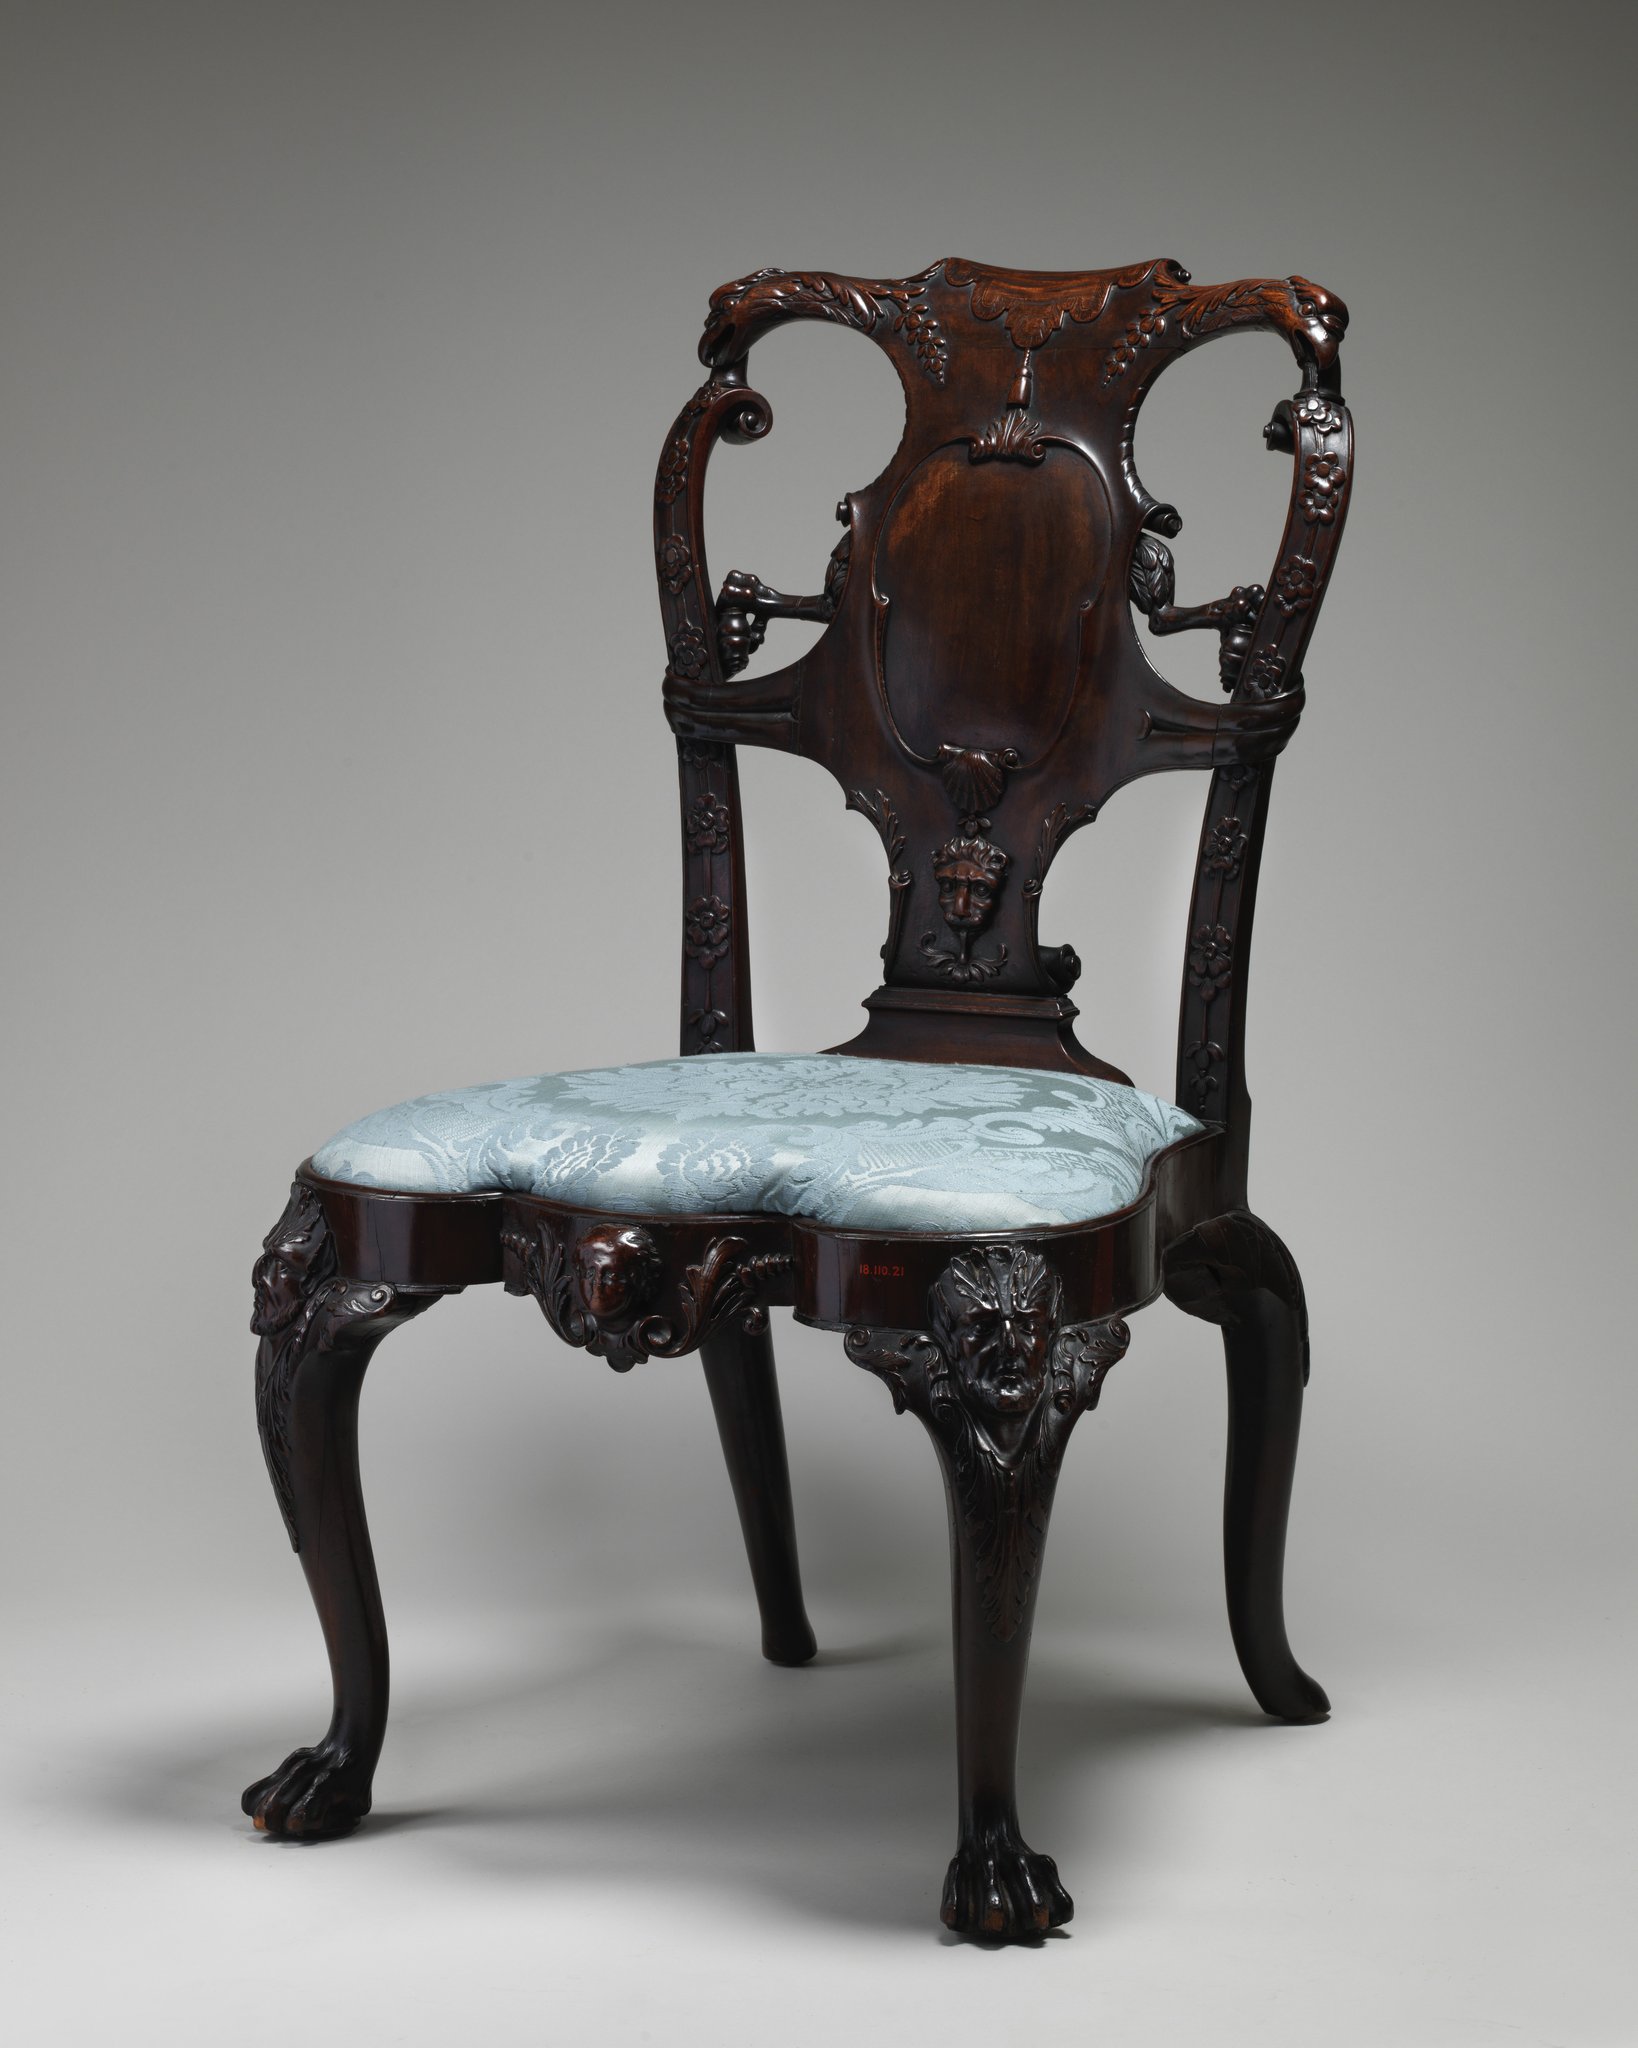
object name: chair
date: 1730-1740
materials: wood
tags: faces